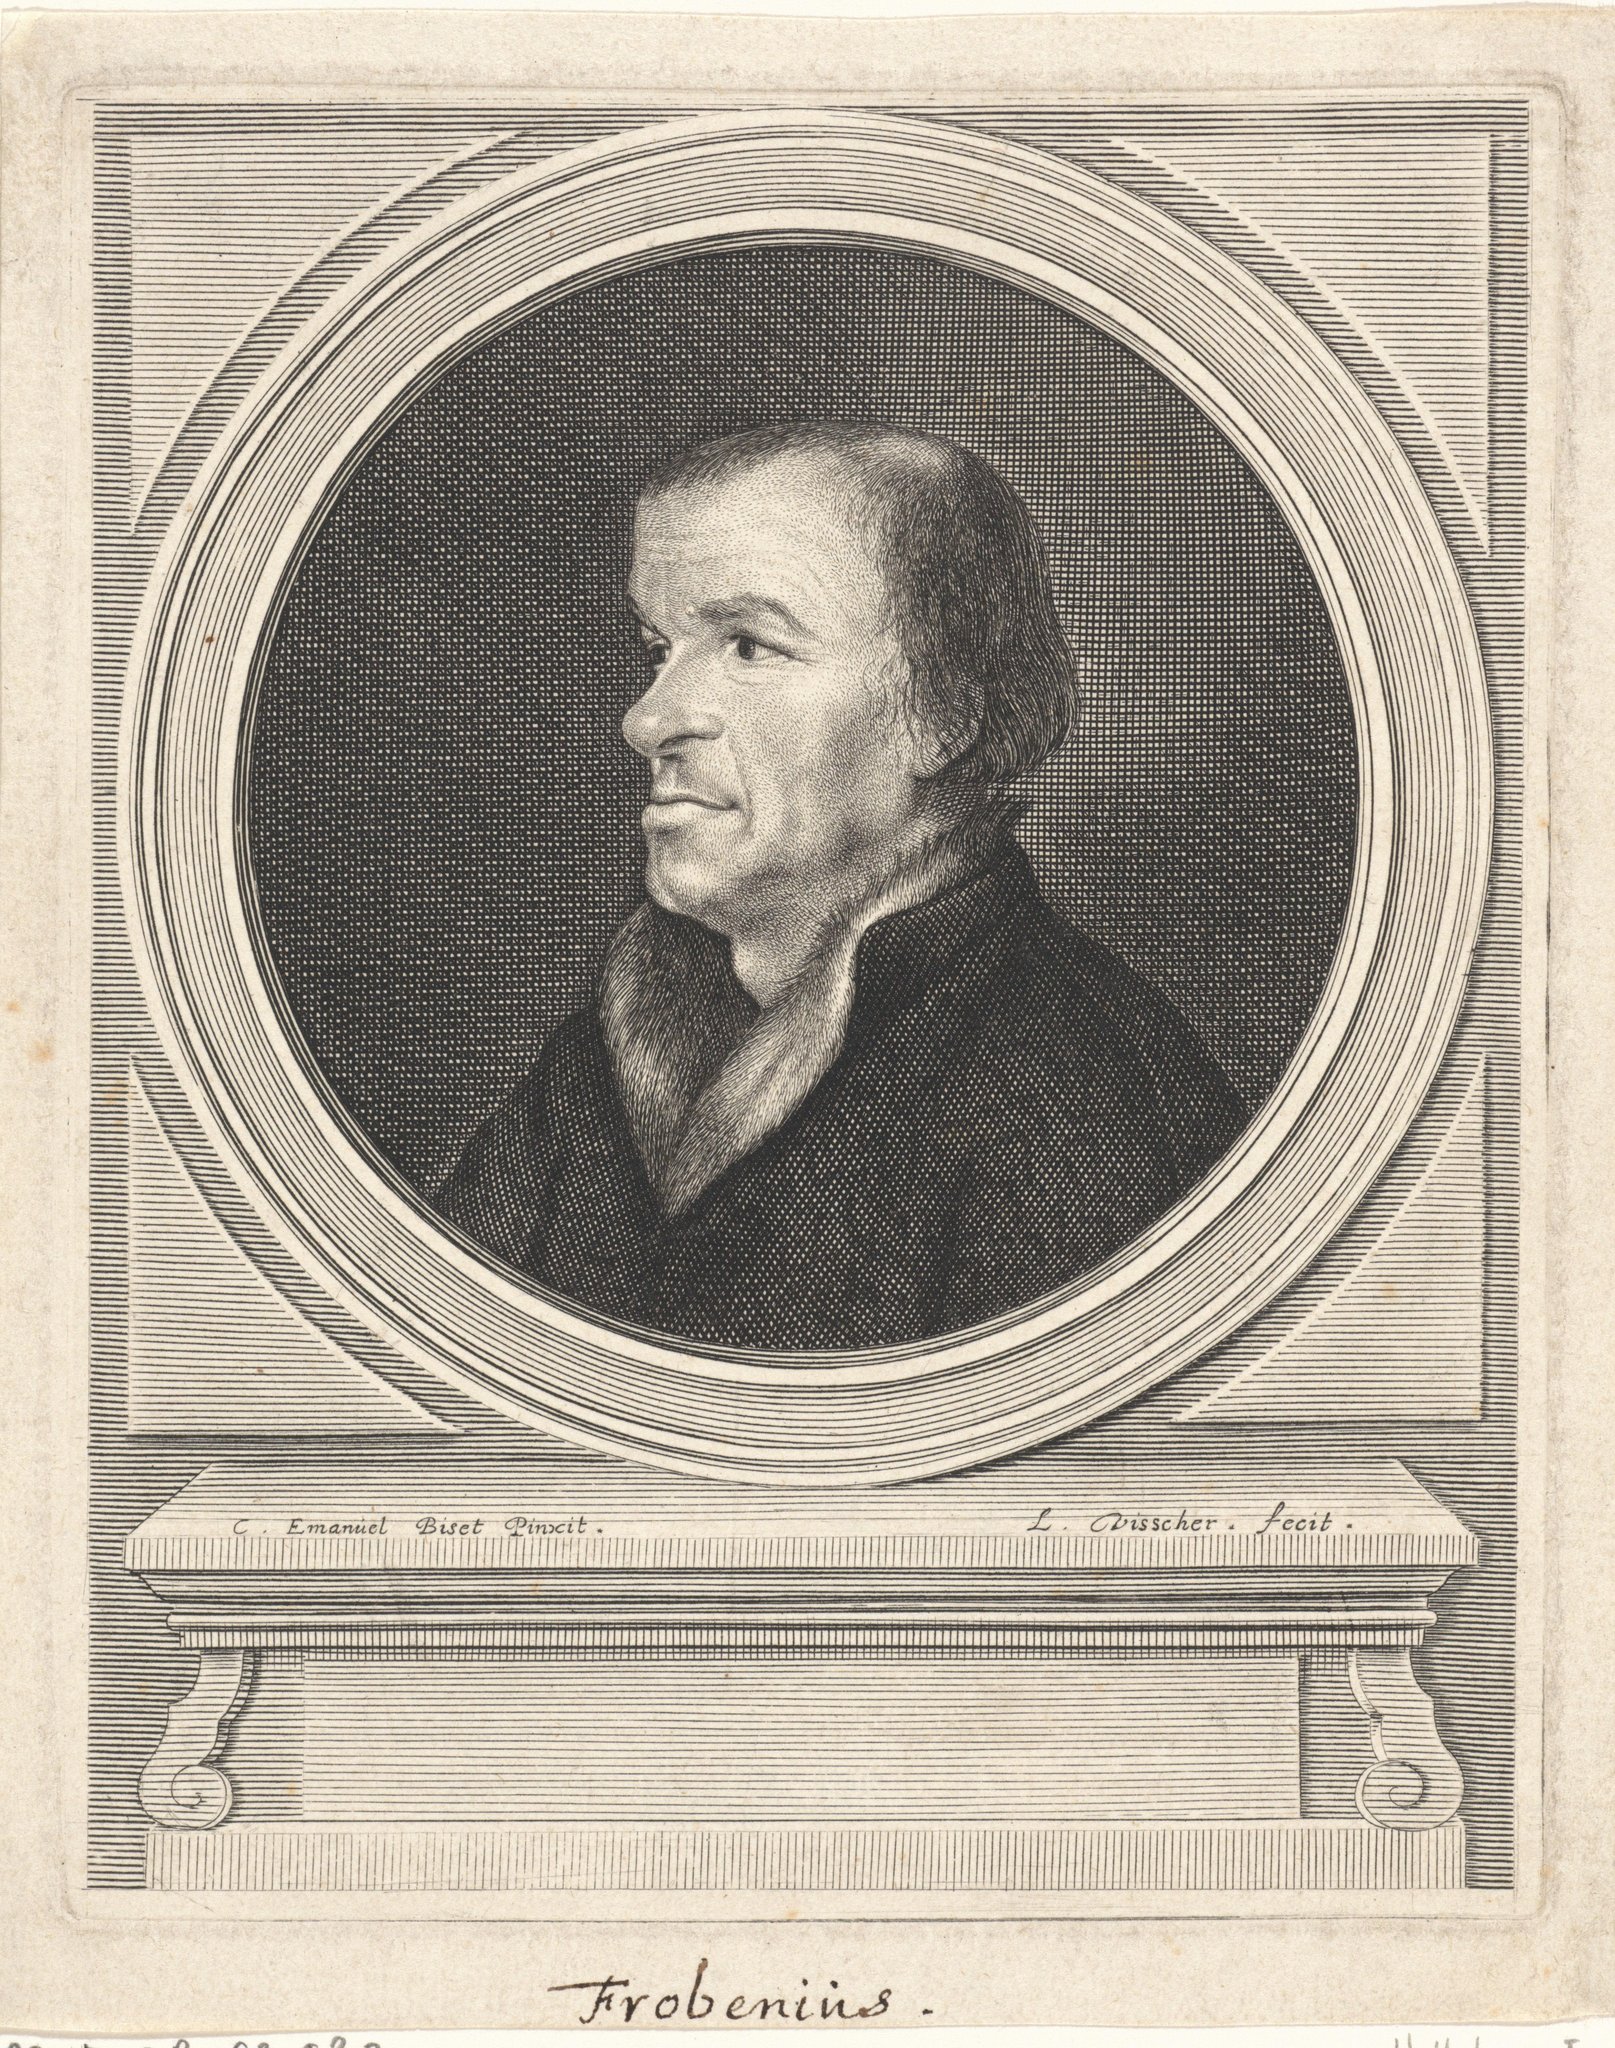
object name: print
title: Portret van Johann Froben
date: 1643-1691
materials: paper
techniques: engraving, etching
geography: northern netherlands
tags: printer, publisher, johann froben, historical persons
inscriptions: collector's mark: Lugt 240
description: De Duitse geleerde, drukker en uitgever Johann Froben (Johannes Frobenius). Hij draagt een jas met een bontkraag.